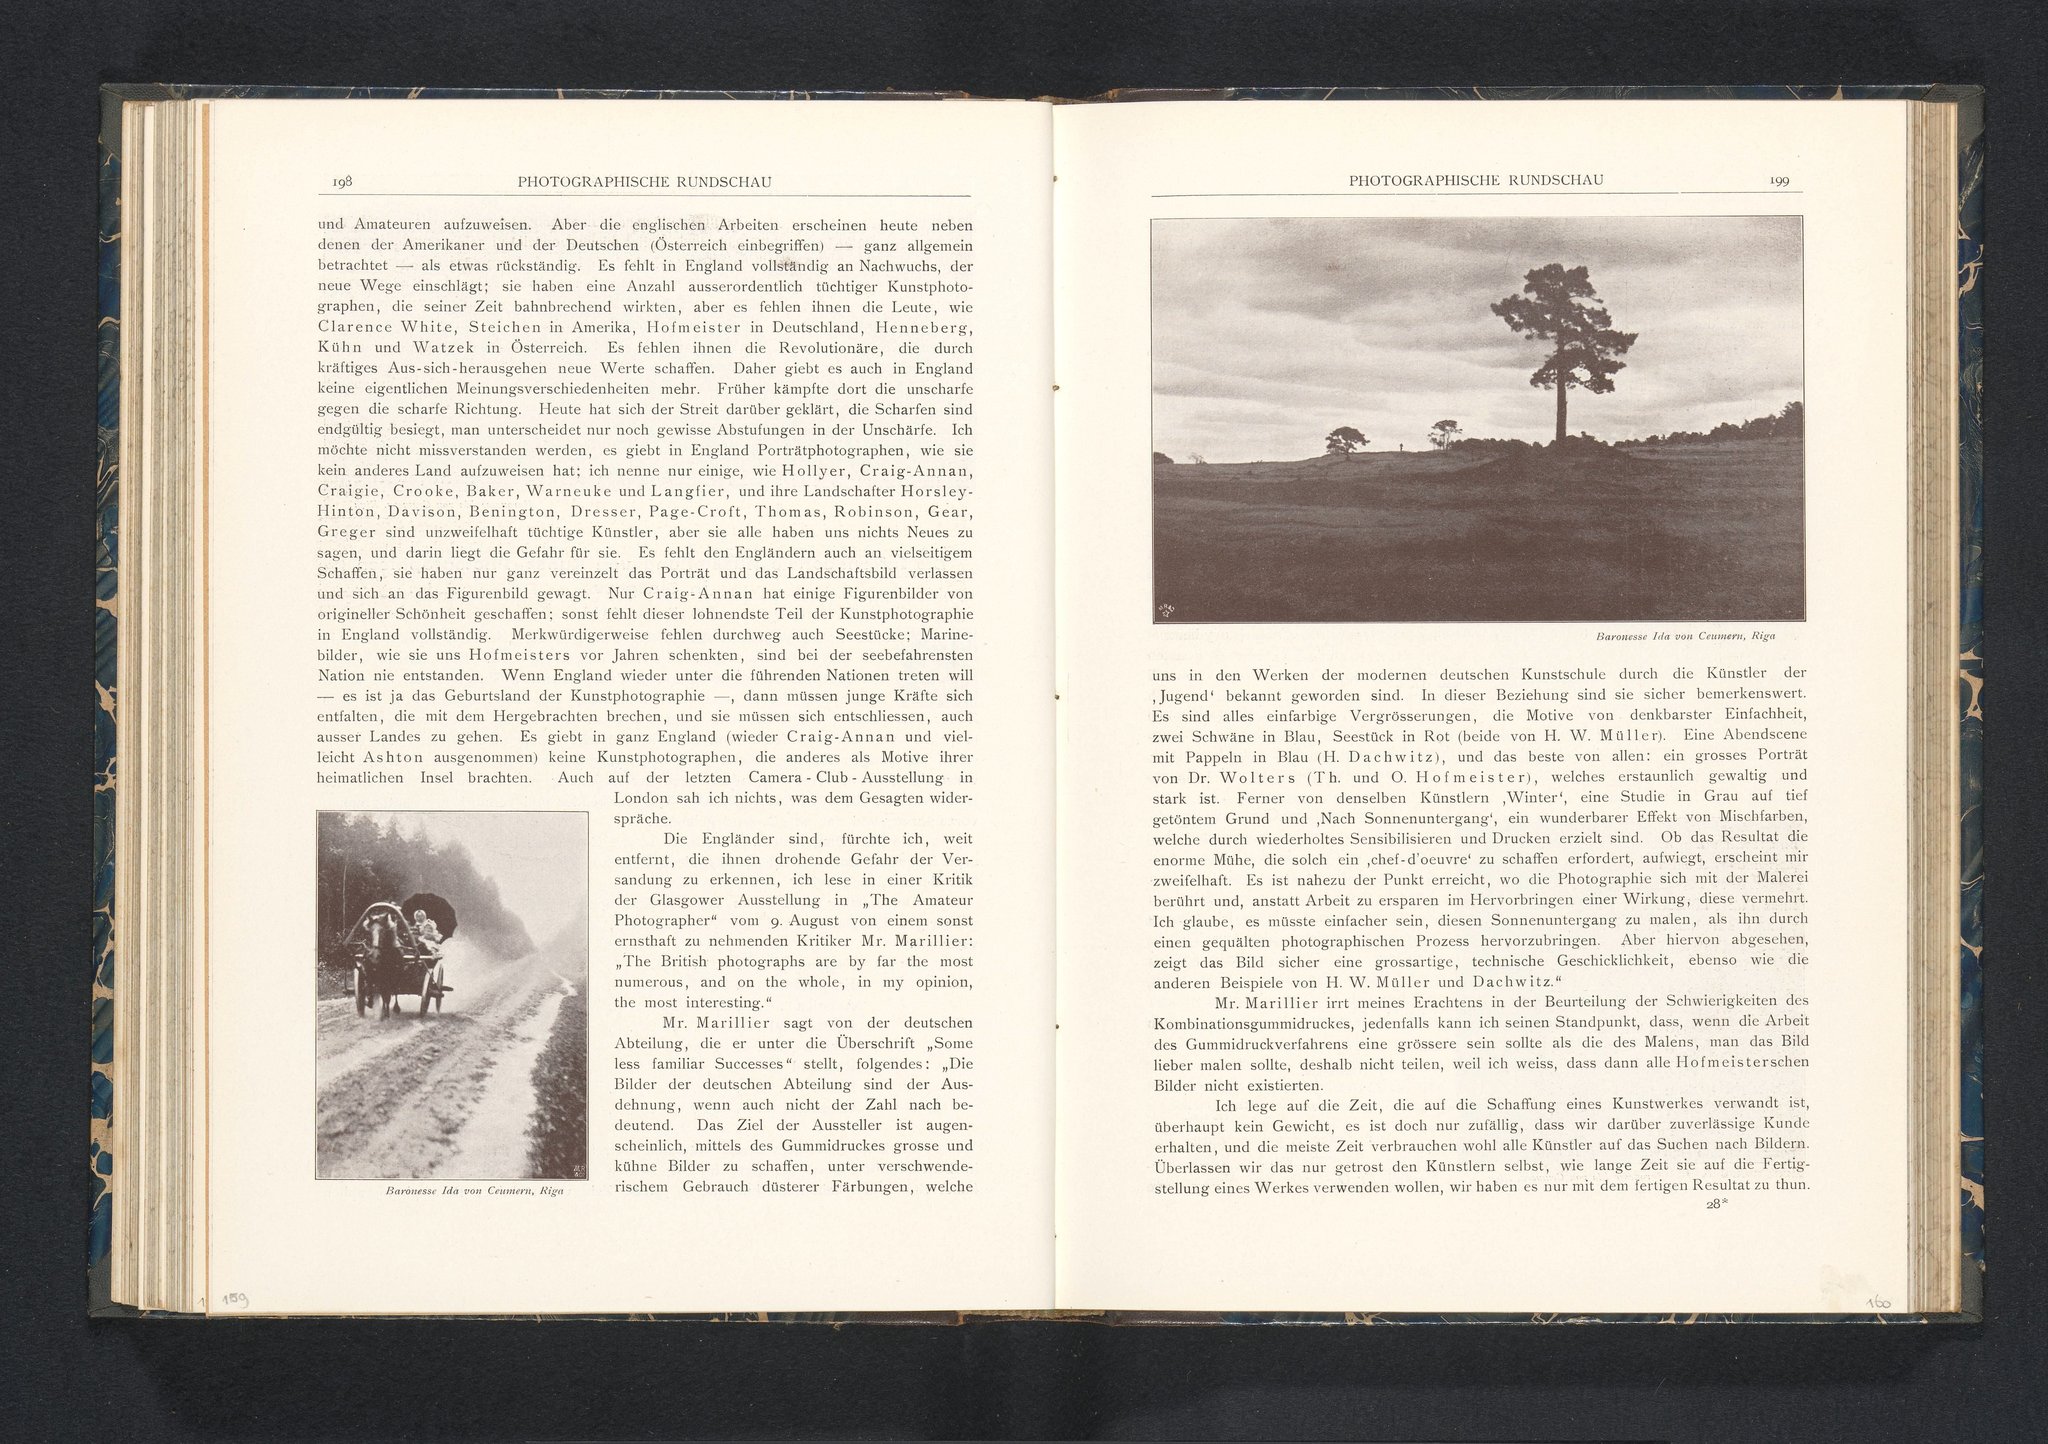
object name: page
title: Landschap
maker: ida von ceumern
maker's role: barones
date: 1896-1901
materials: paper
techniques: autotype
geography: berlin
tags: landscapes